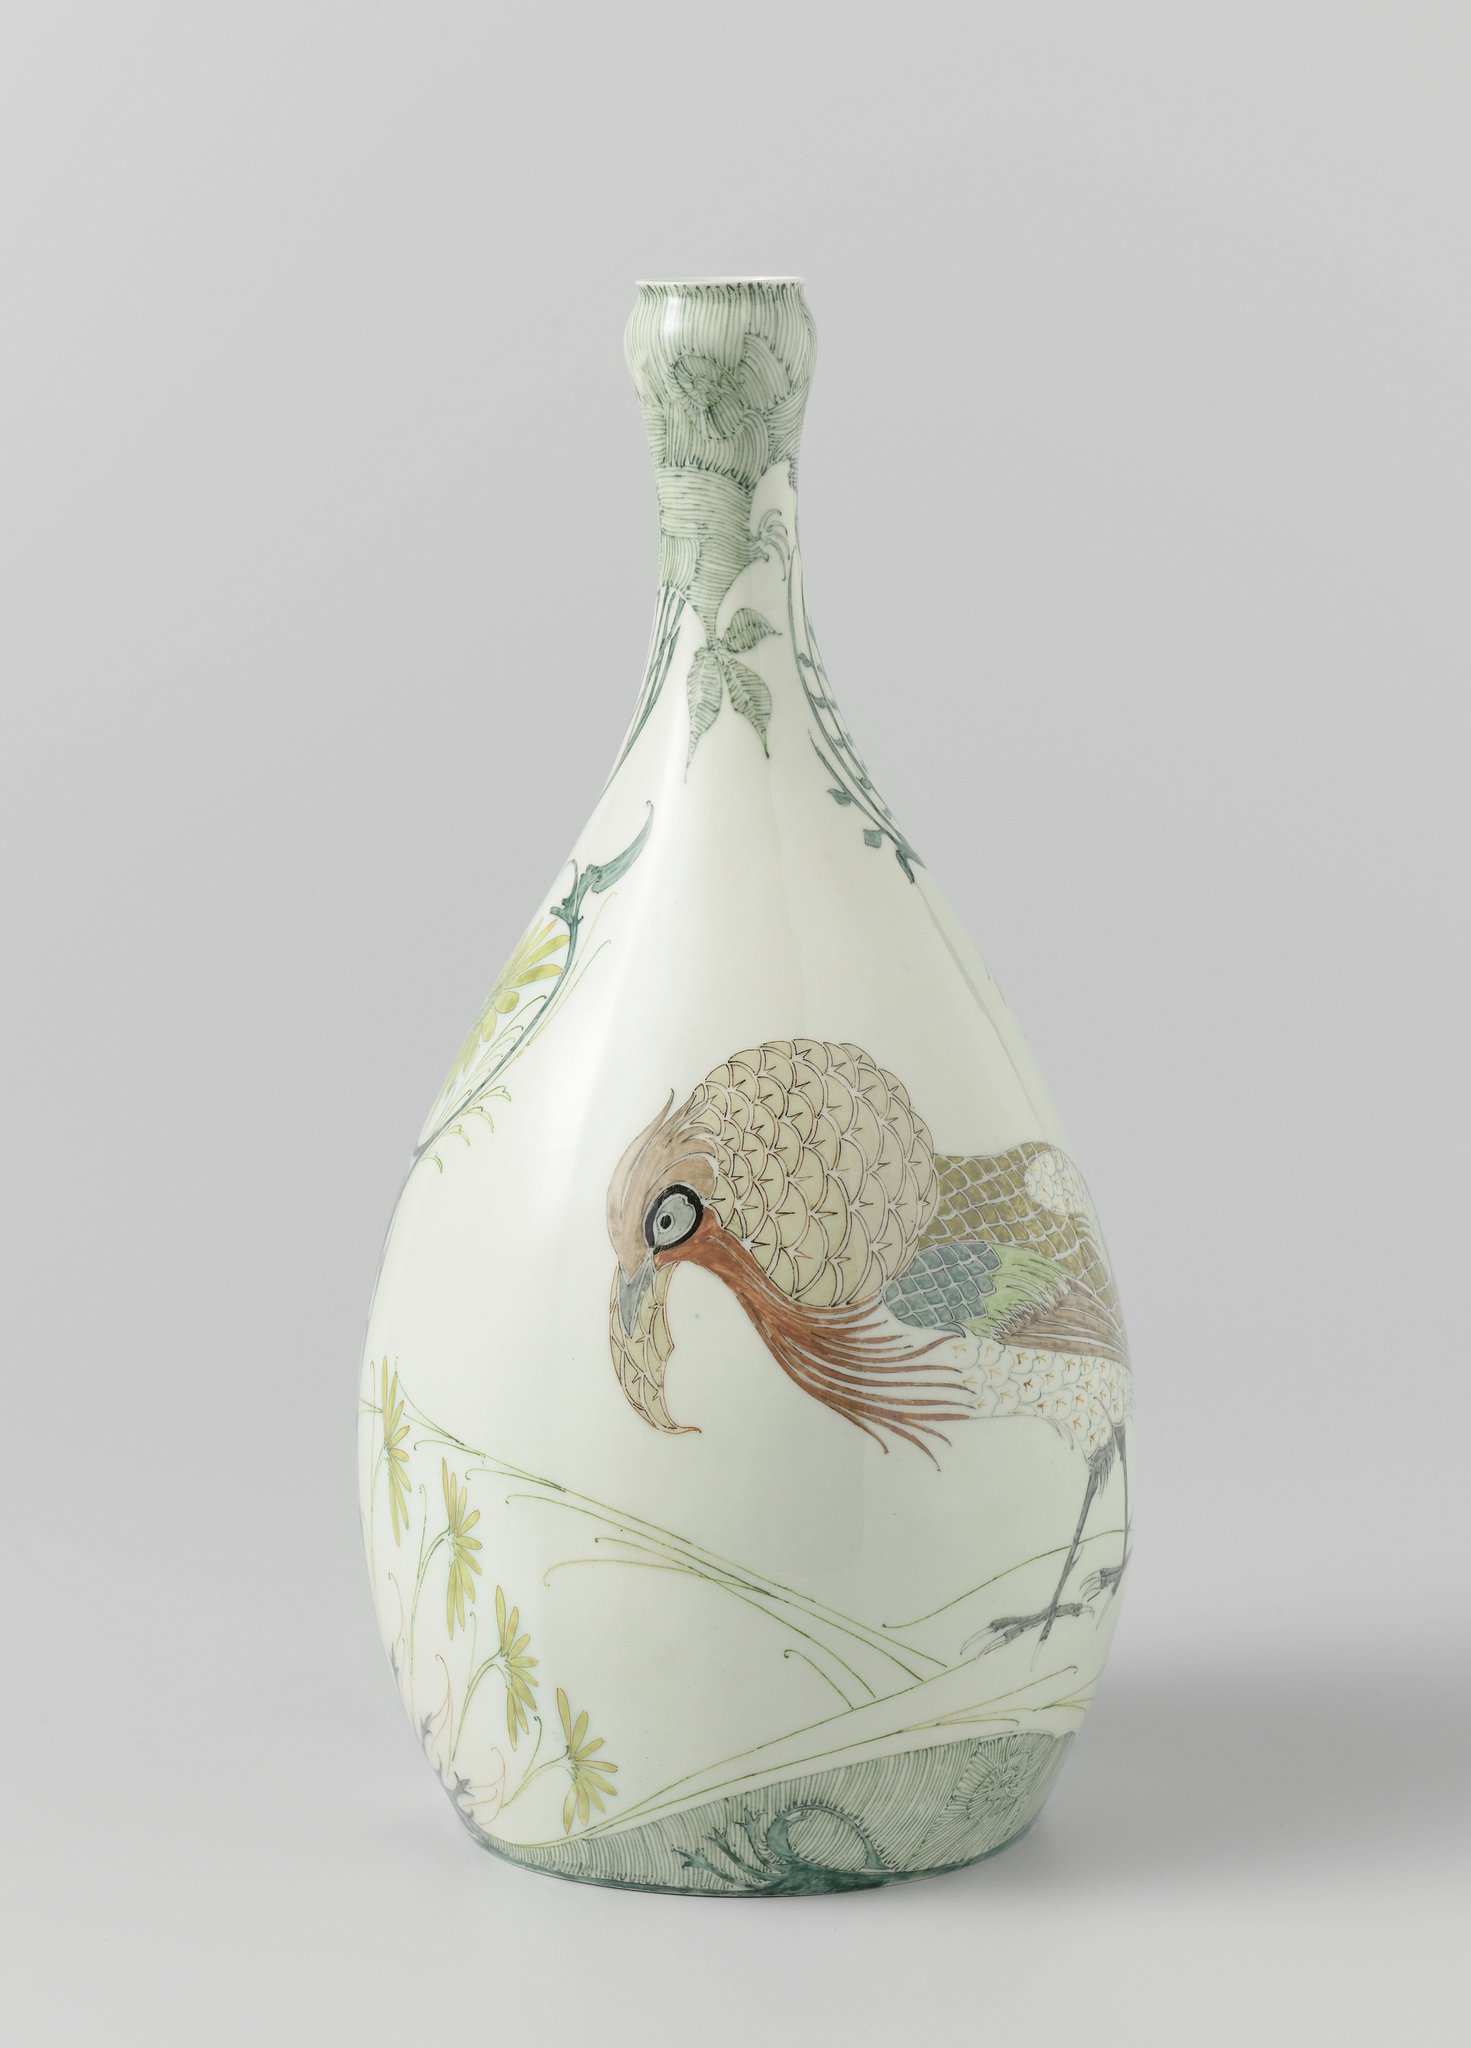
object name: vase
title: Vaas beschilderd met een fazant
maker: sam schellink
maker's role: ceramicist, draughtsman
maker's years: 1876-1958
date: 1900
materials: porcelain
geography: the hague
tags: walker and runner birds: pheasant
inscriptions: mark: ‘stempel in groen: Rozenburg/ooievaar/ Den Haag; in zwart: links een bij (=1900); rechts werkordernummer 61 en schildersmerk JS; in reliëf modelnummer 101’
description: Vase, 1900, decorated by Samuel Schellink, model no 101.